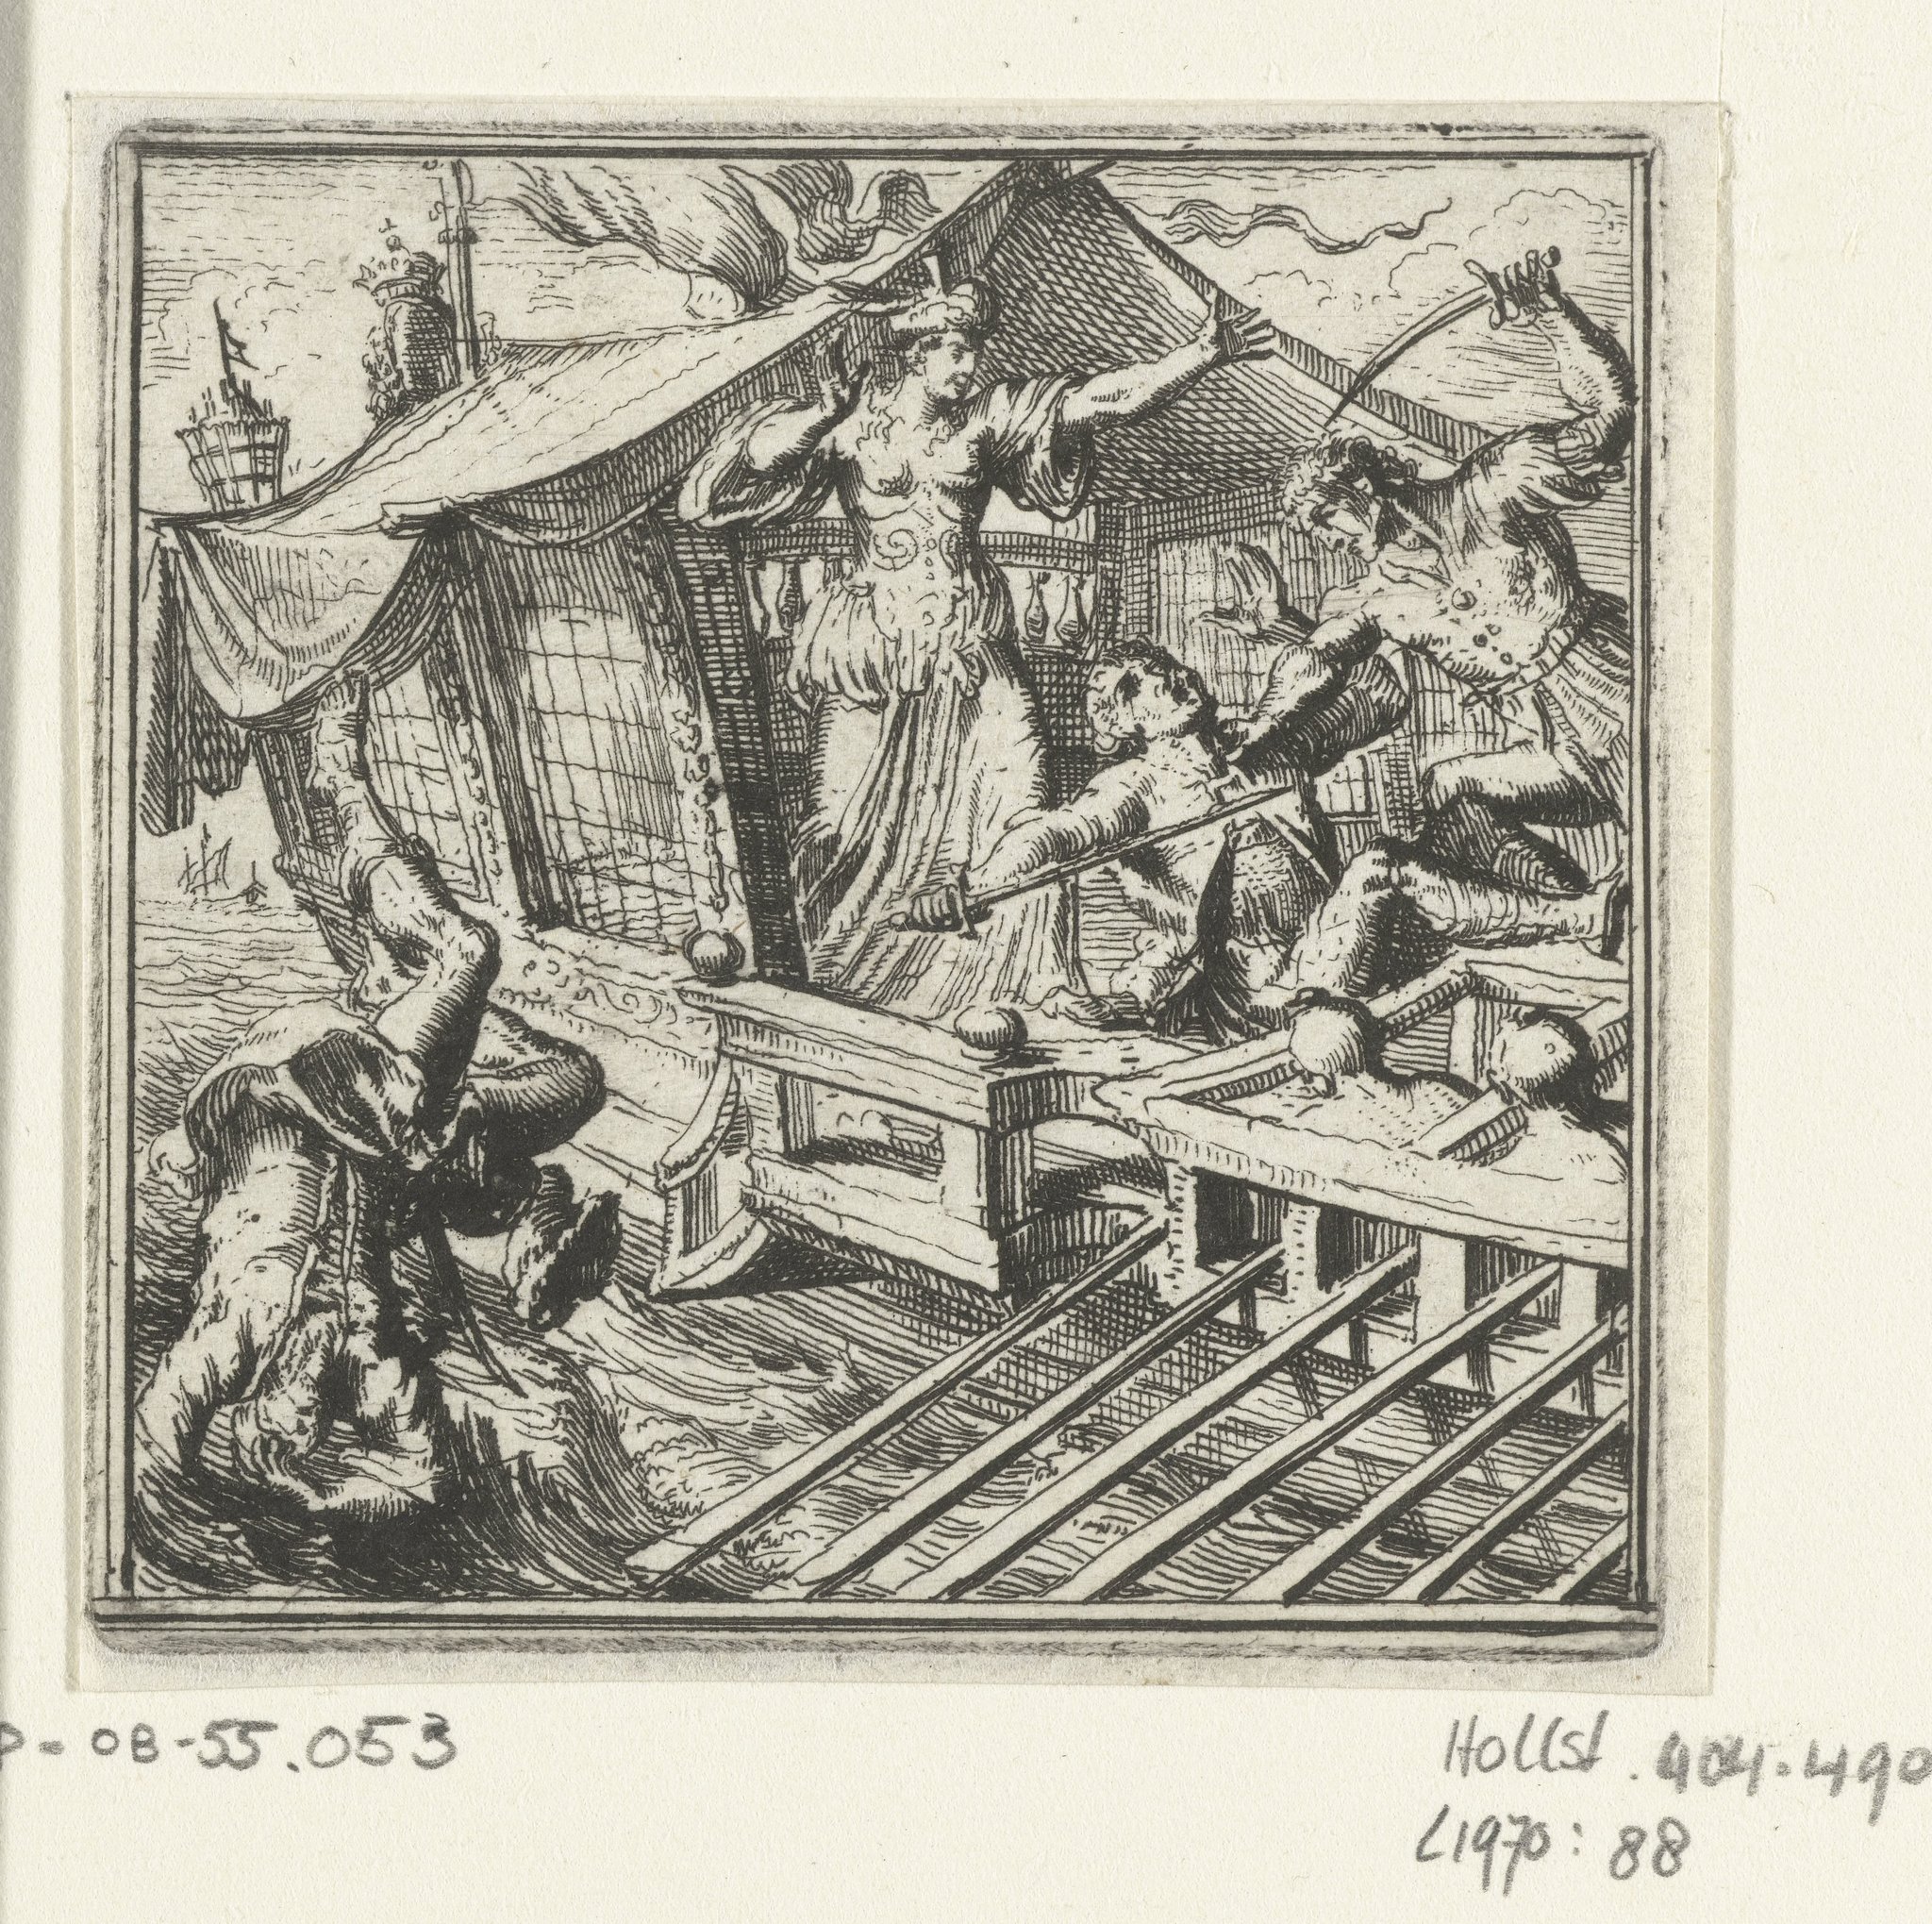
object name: book illustration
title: Illustratie voor de Decamerone van Boccaccio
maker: romeyn de hooghe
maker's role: draughtsman, goldsmith, painter, print maker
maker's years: 1645-1708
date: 1697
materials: paper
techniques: etching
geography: netherlands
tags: (scenes from) specific works of literature: boccaccio, decamerone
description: Illustratie voor: Contes et nouvelles de Bocace Florentin. Traduction libre, 2 delen, Amsterdam, George Gallet, 1697. Latere edities met dezelfde illustraties uit 1699, 1702, 1732.